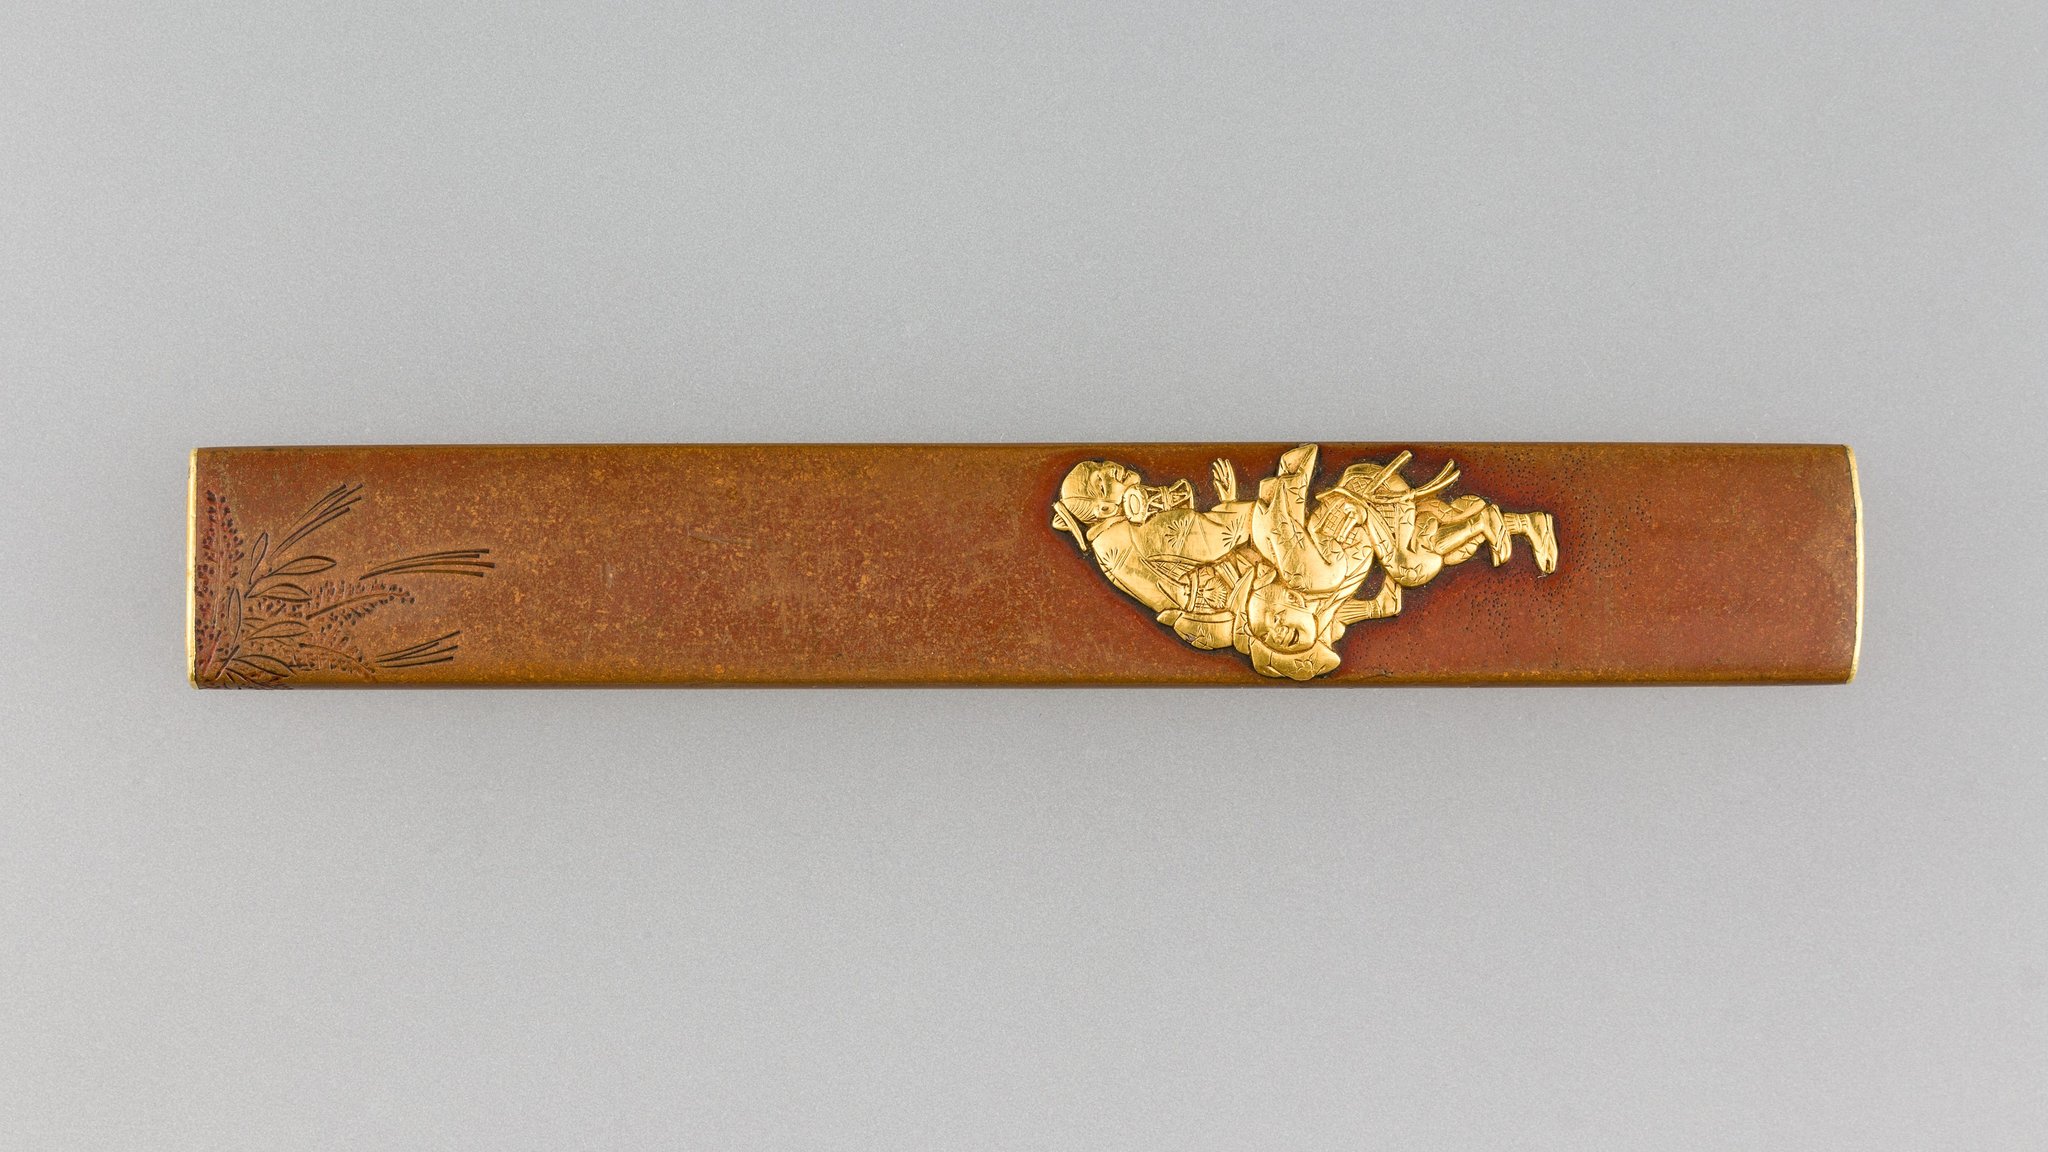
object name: knife handle kozuka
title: Knife Handle (Kozuka)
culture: japanese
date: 1780-1876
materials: copper, gold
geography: japan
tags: men